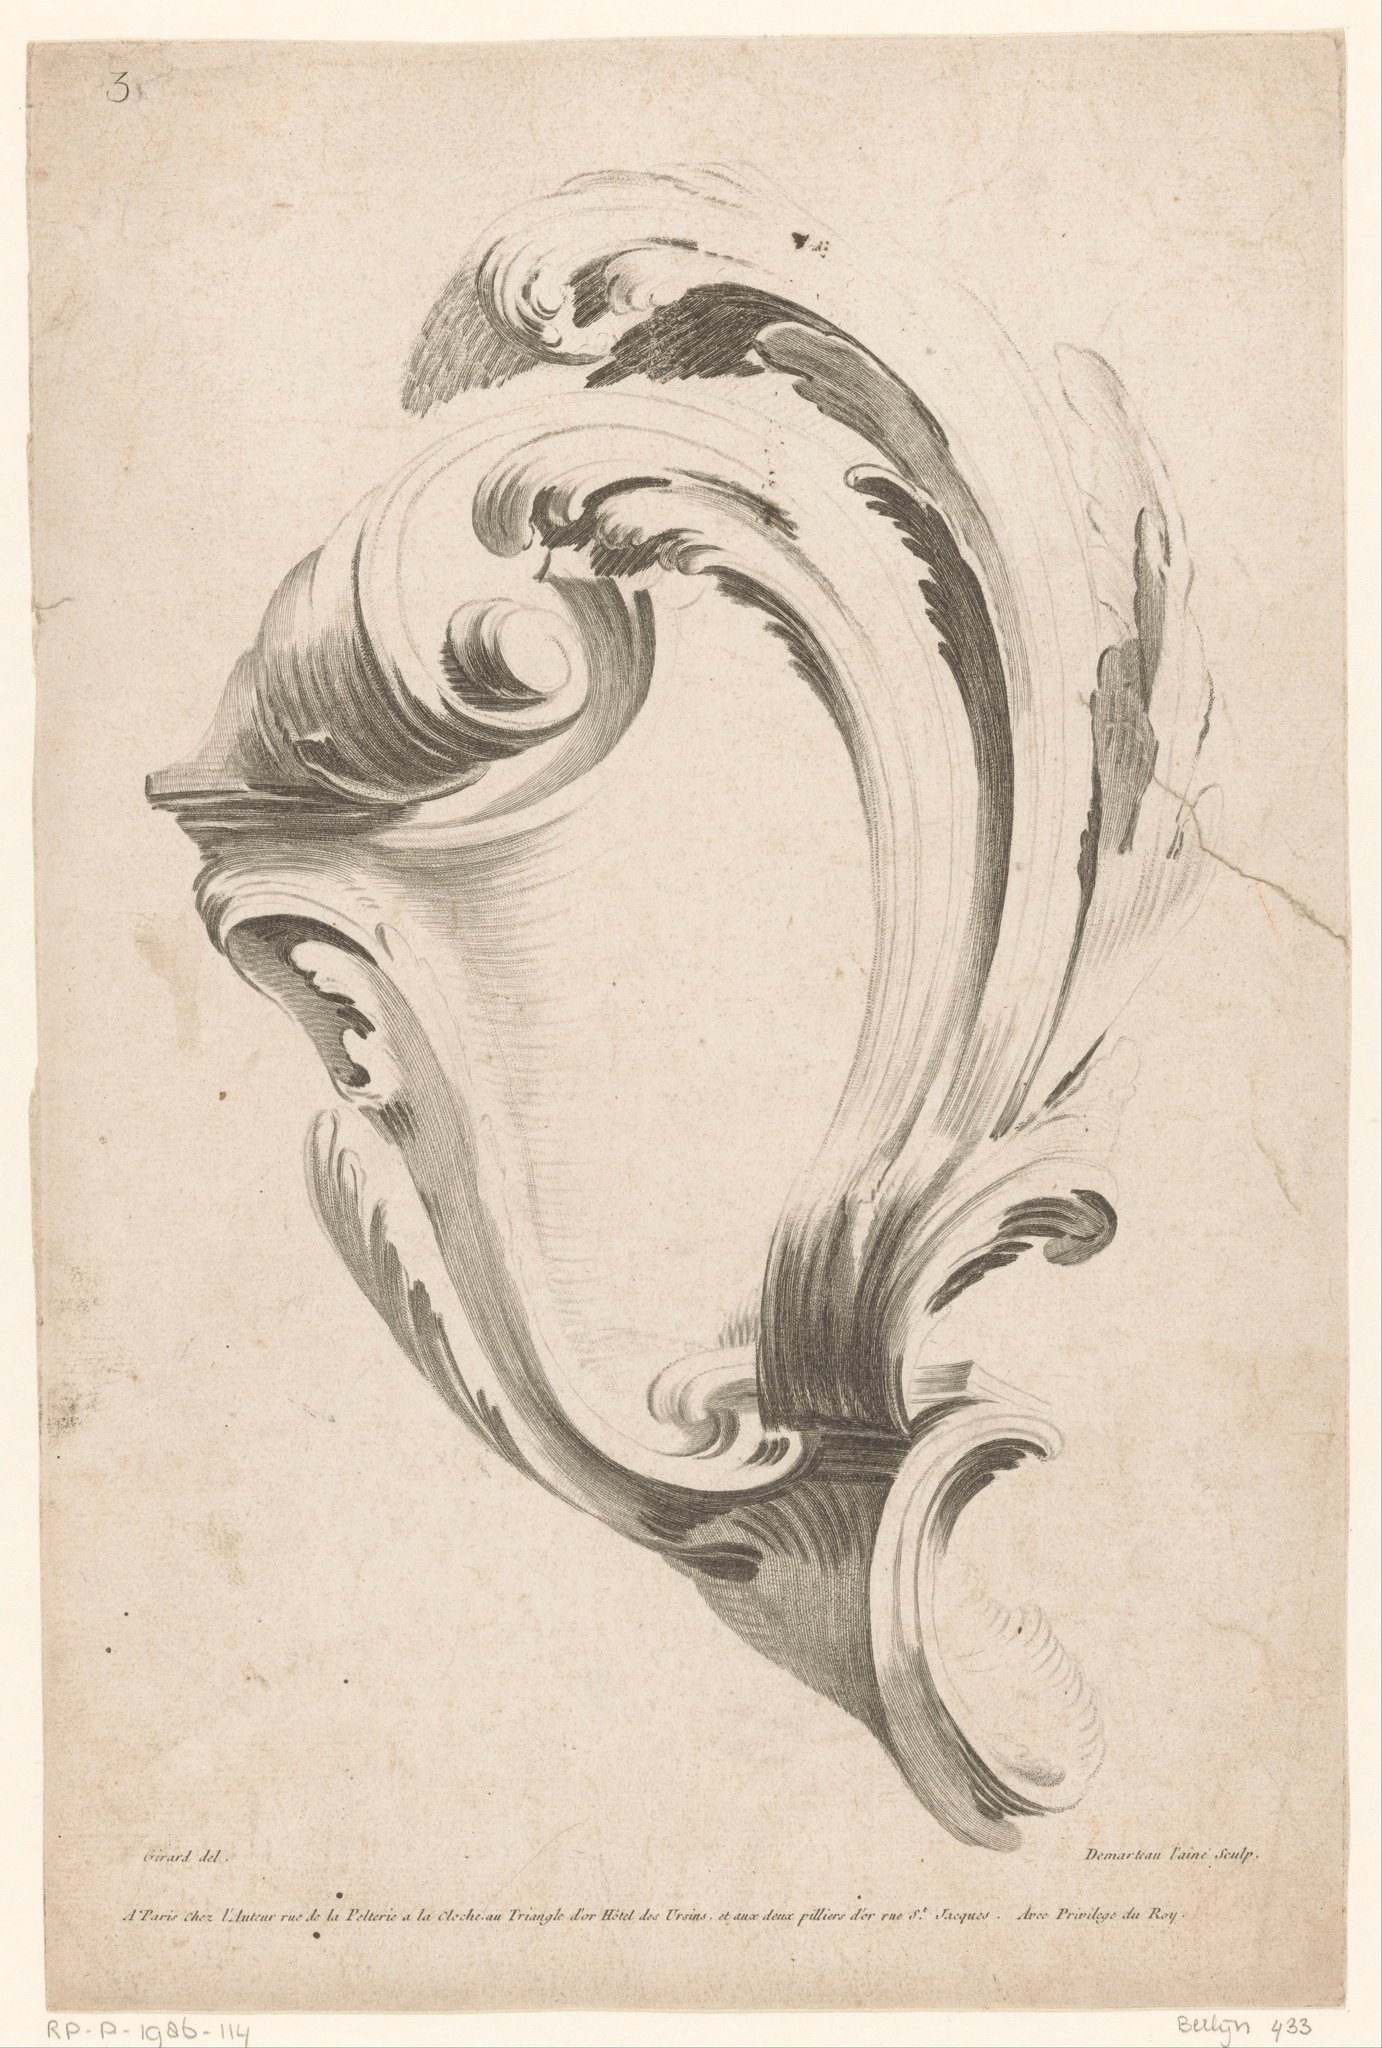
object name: print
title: Rocaille cartouche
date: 1761-1769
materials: paper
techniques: etching, roulette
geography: paris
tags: rocaille ornament, ornament ~ cartouche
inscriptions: collector's mark: Lugt 2760, collector's mark: Lugt 2228